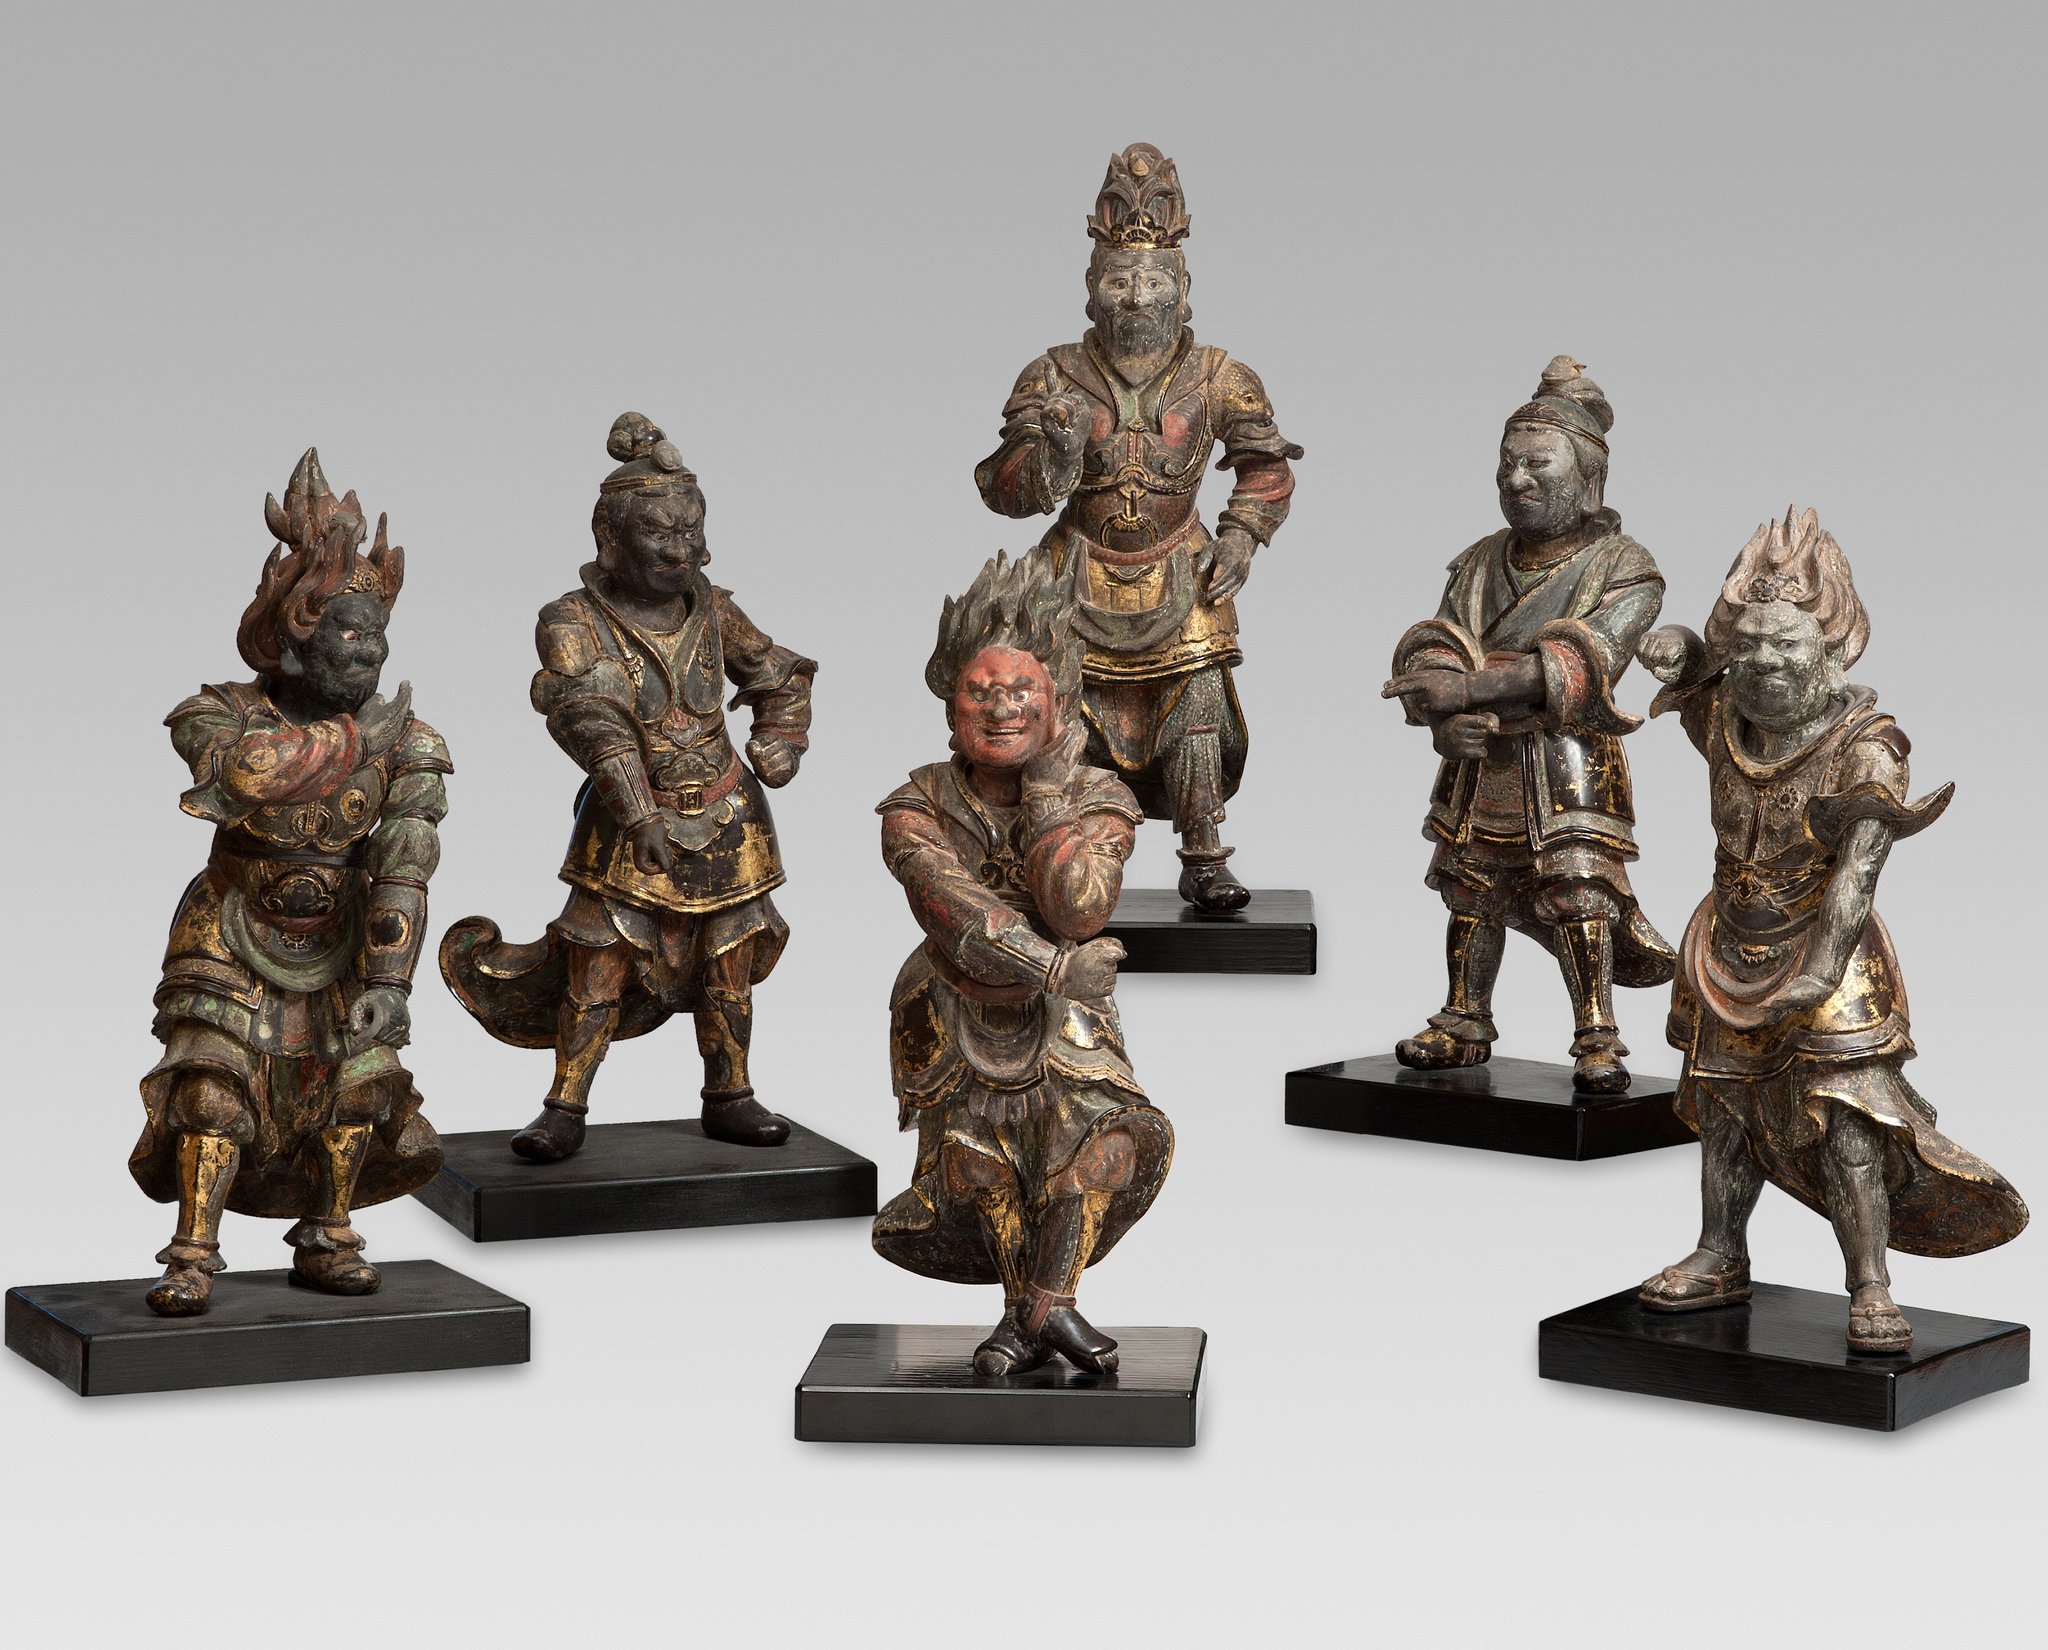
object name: figure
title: Six of the Twelve Divine Generals (Jūni shinshō)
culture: japanese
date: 1301-1333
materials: crystal, gold, lacquer, wood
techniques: inlay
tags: men,buddhism,zodiac